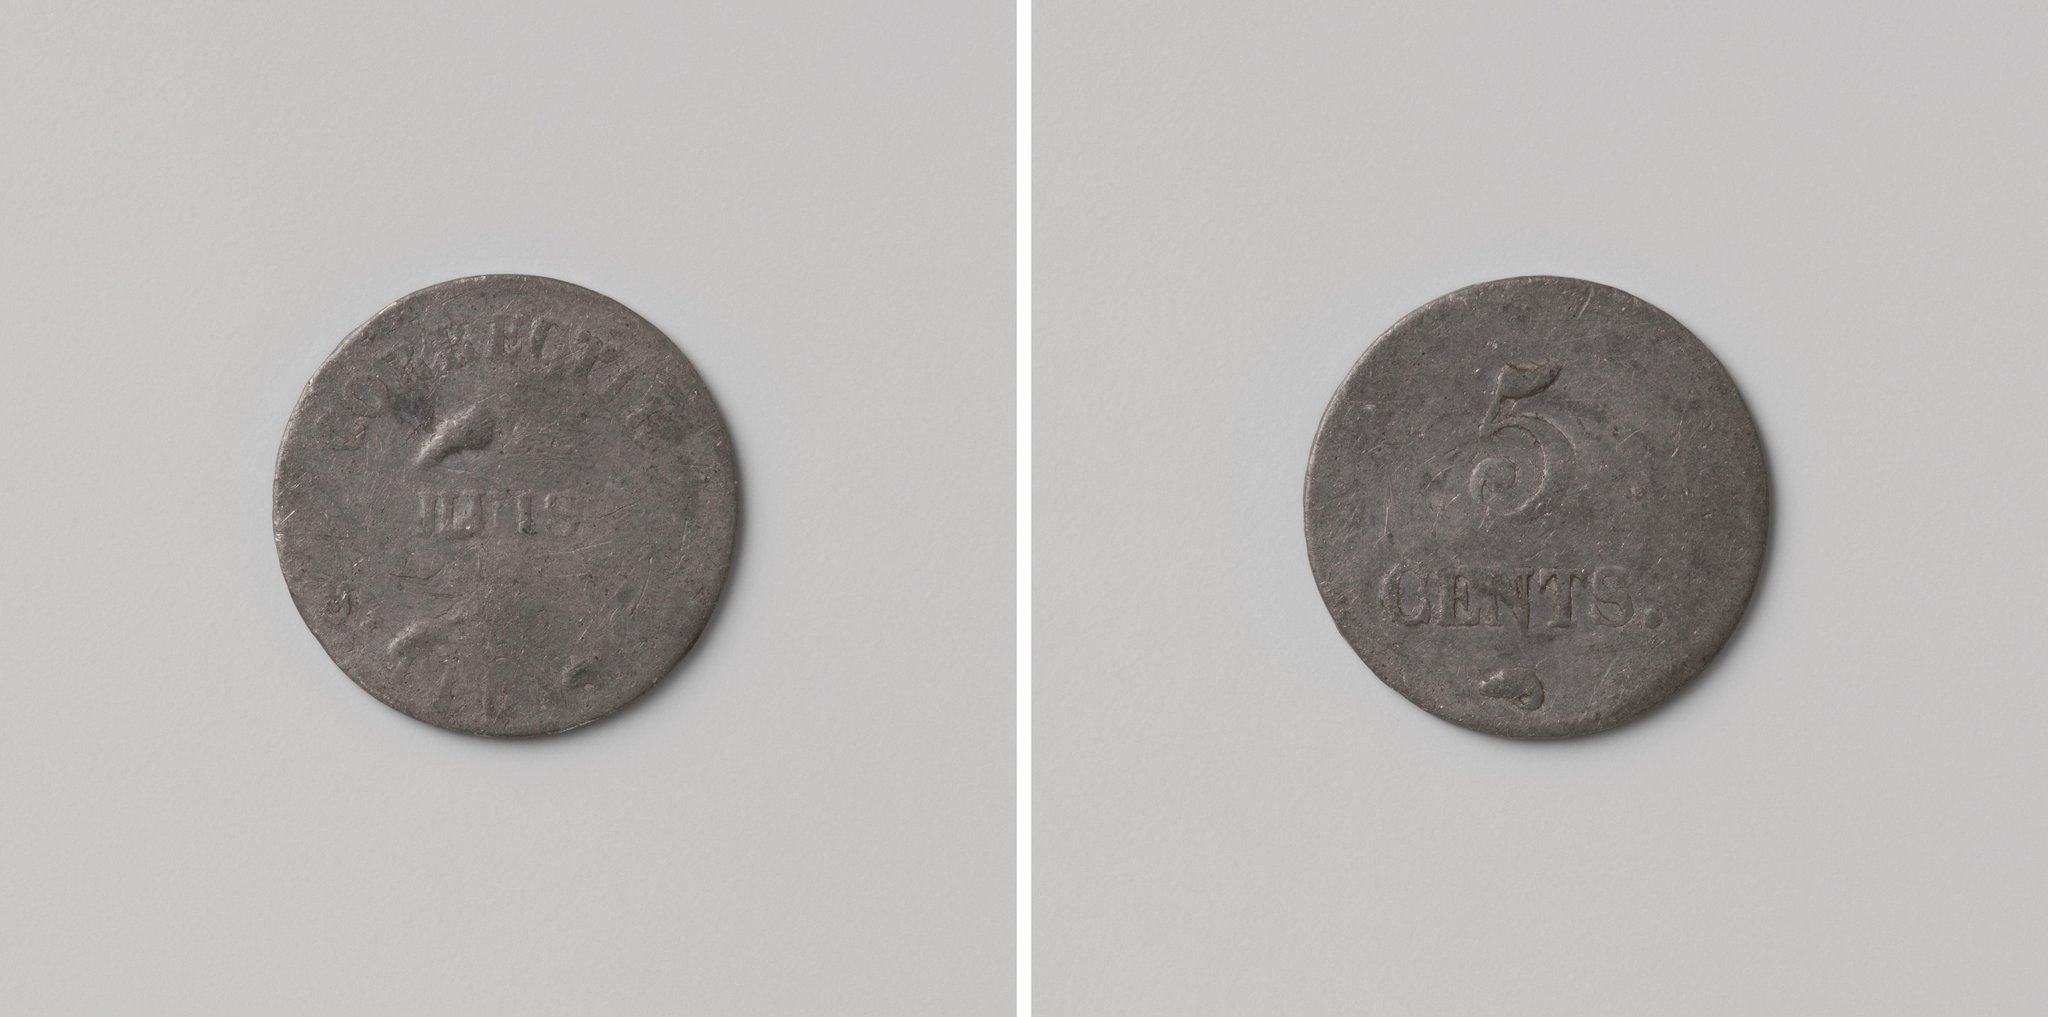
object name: monetary token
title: Correctiehuis Sint Bernhard te Hemiksem, huismunt ter waarde van vijf cents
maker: joseph pierre braemt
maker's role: print maker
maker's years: 1796-1864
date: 1826-1833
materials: zinc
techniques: striking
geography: brussels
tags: ghent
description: Zinken betaalpenning. Voorzijde: opschrift binnen omschrift. Keerzijde: waardeaanduiding.